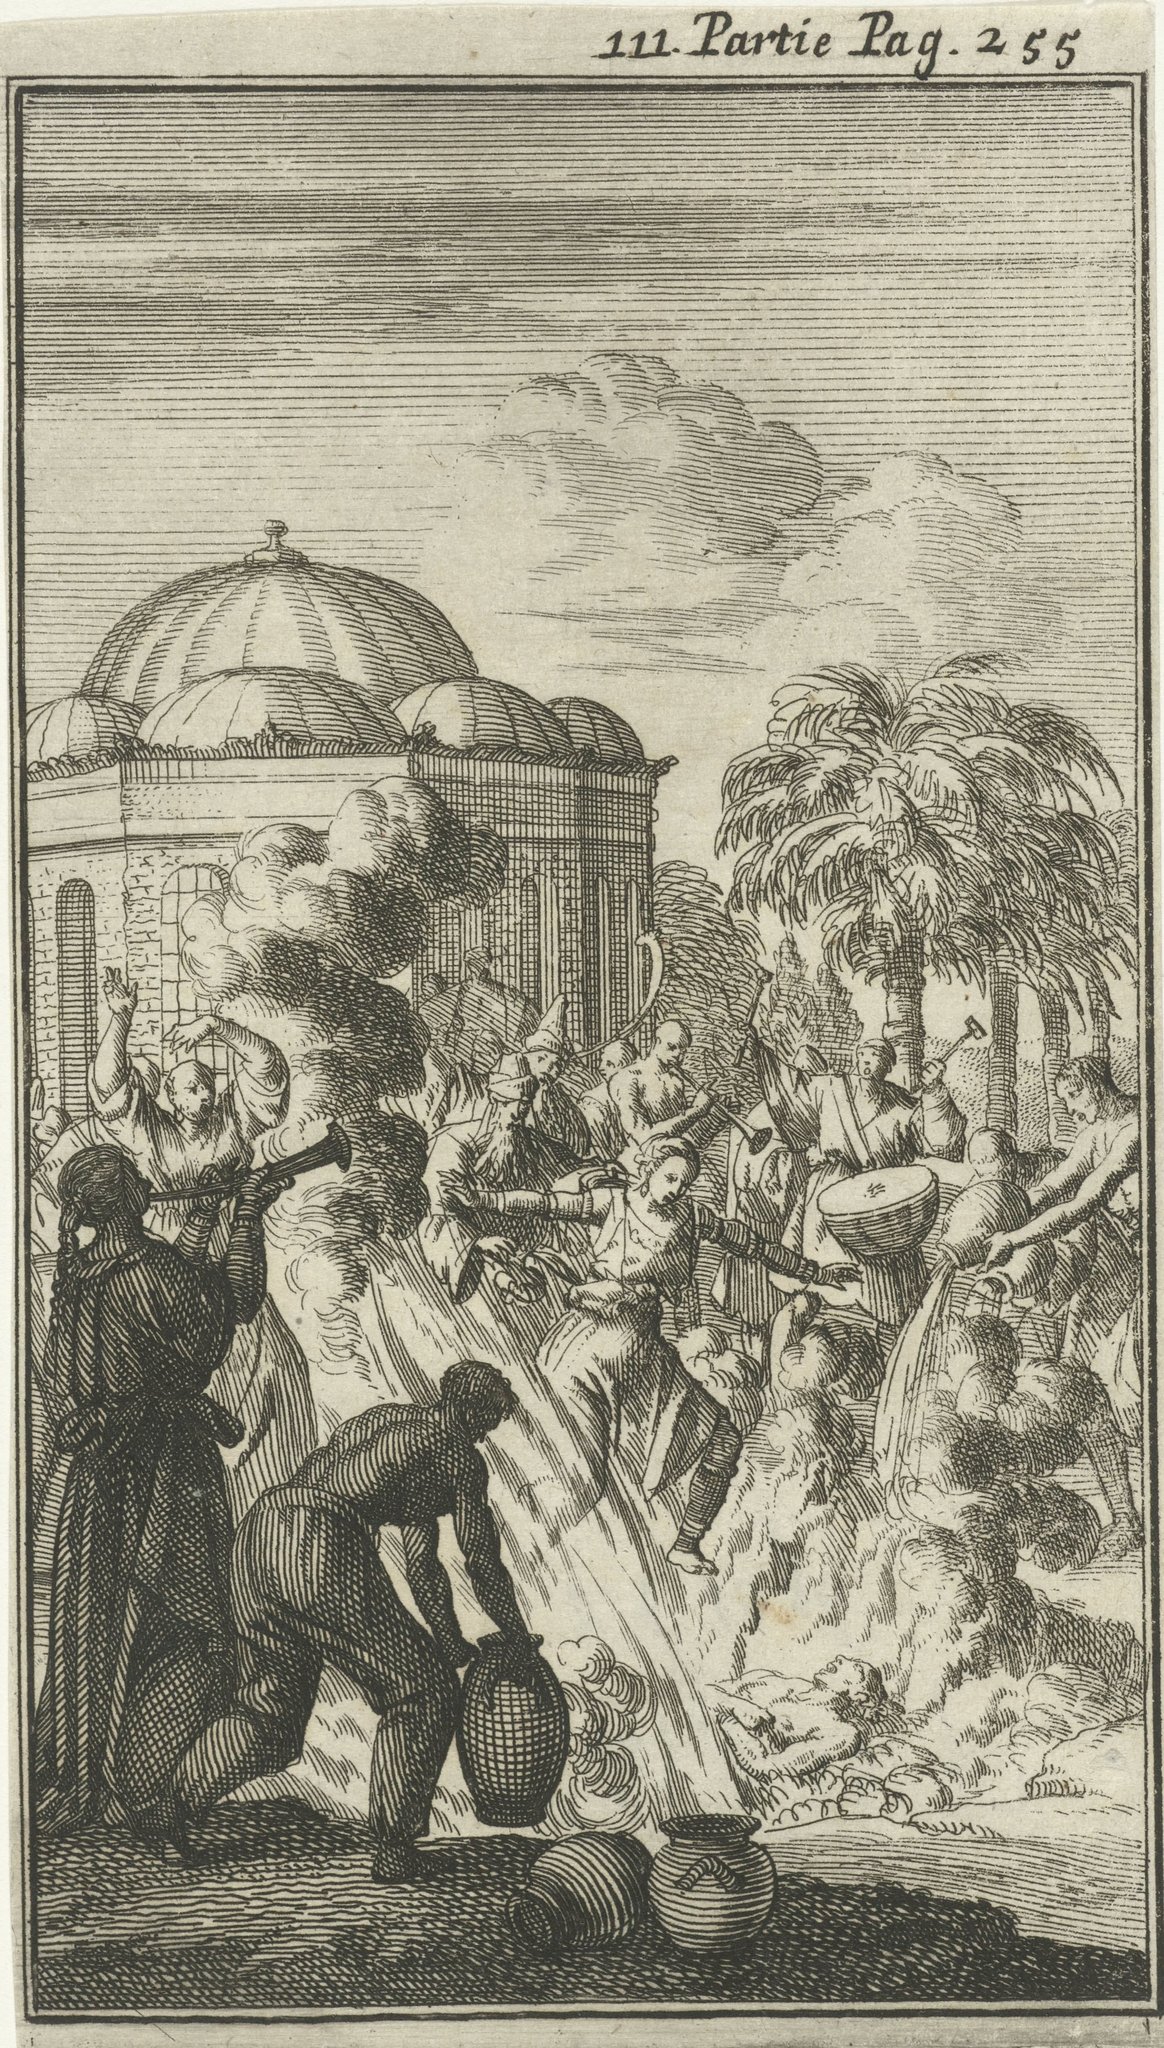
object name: book illustration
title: Verbranden van het lijk van een Brahmaan waarbij de weduwe zich in de vlammen stort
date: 1689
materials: paper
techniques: etching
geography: paris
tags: widow, body-burning, cremation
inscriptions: collector's mark: Lugt 2228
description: Illustratie uit: Thevenot, Jean de. Voyages Tant en Europe qu'en Asie et en Afrique, 4 delen. Parijs: Charles Angot, 1689, dl. IV.